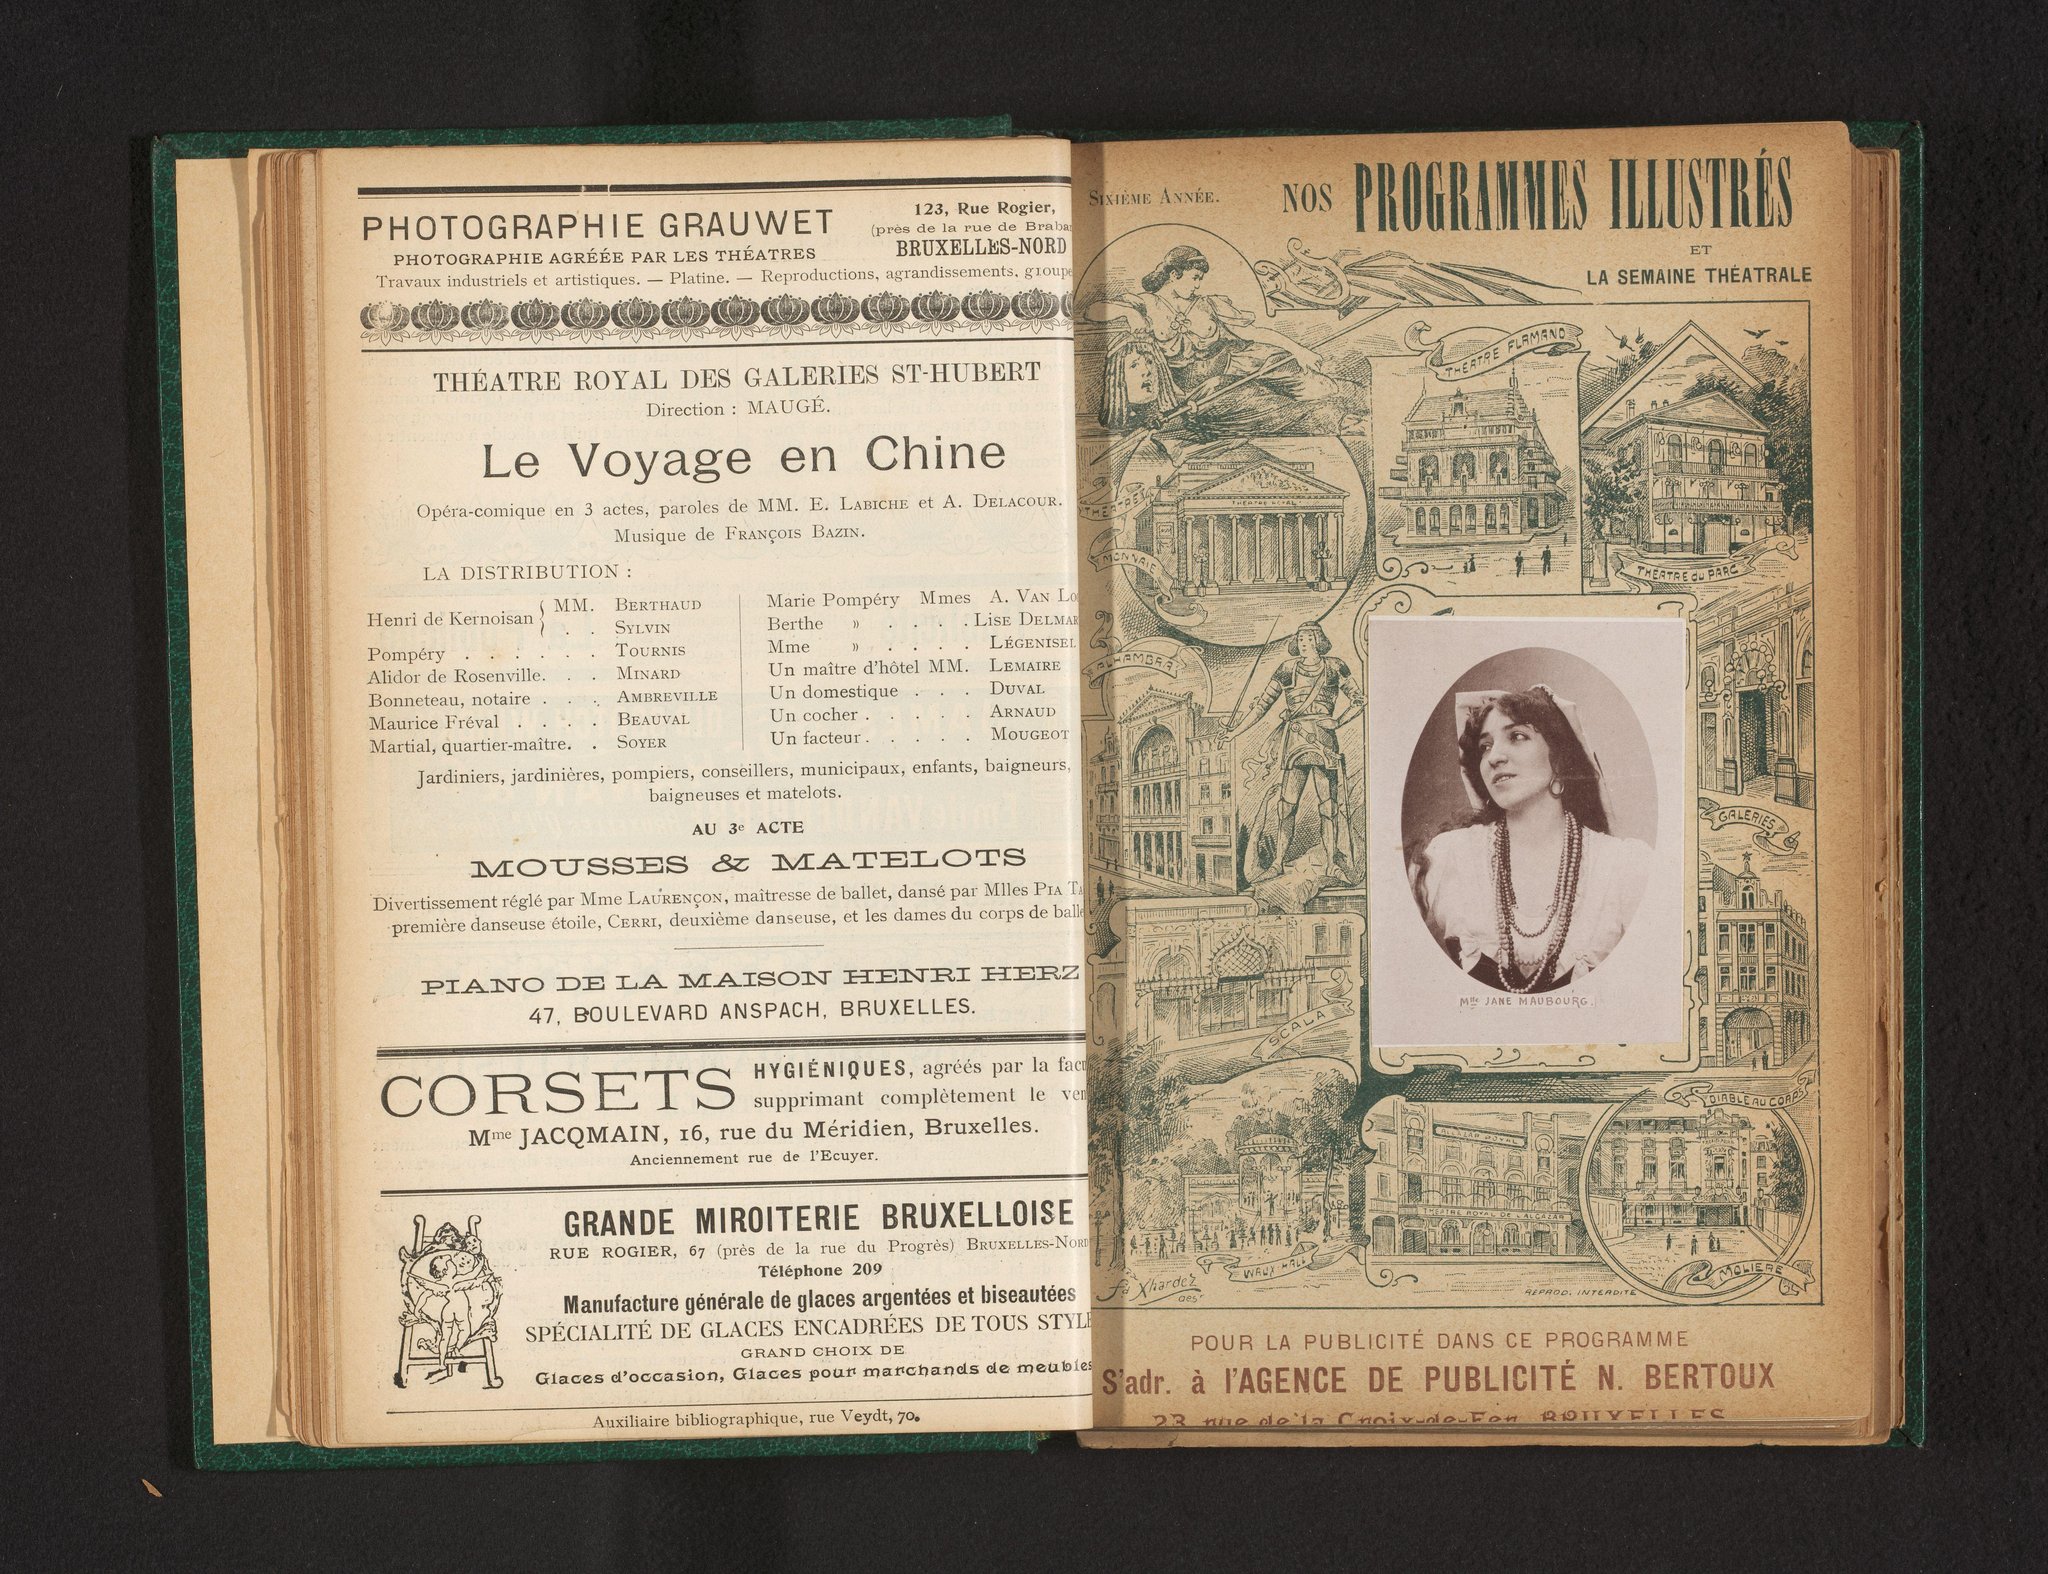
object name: photomechanical print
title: Mlle Jane Maubourg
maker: Anonymous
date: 1895-1900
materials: paper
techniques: photograph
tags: adult woman, historical persons